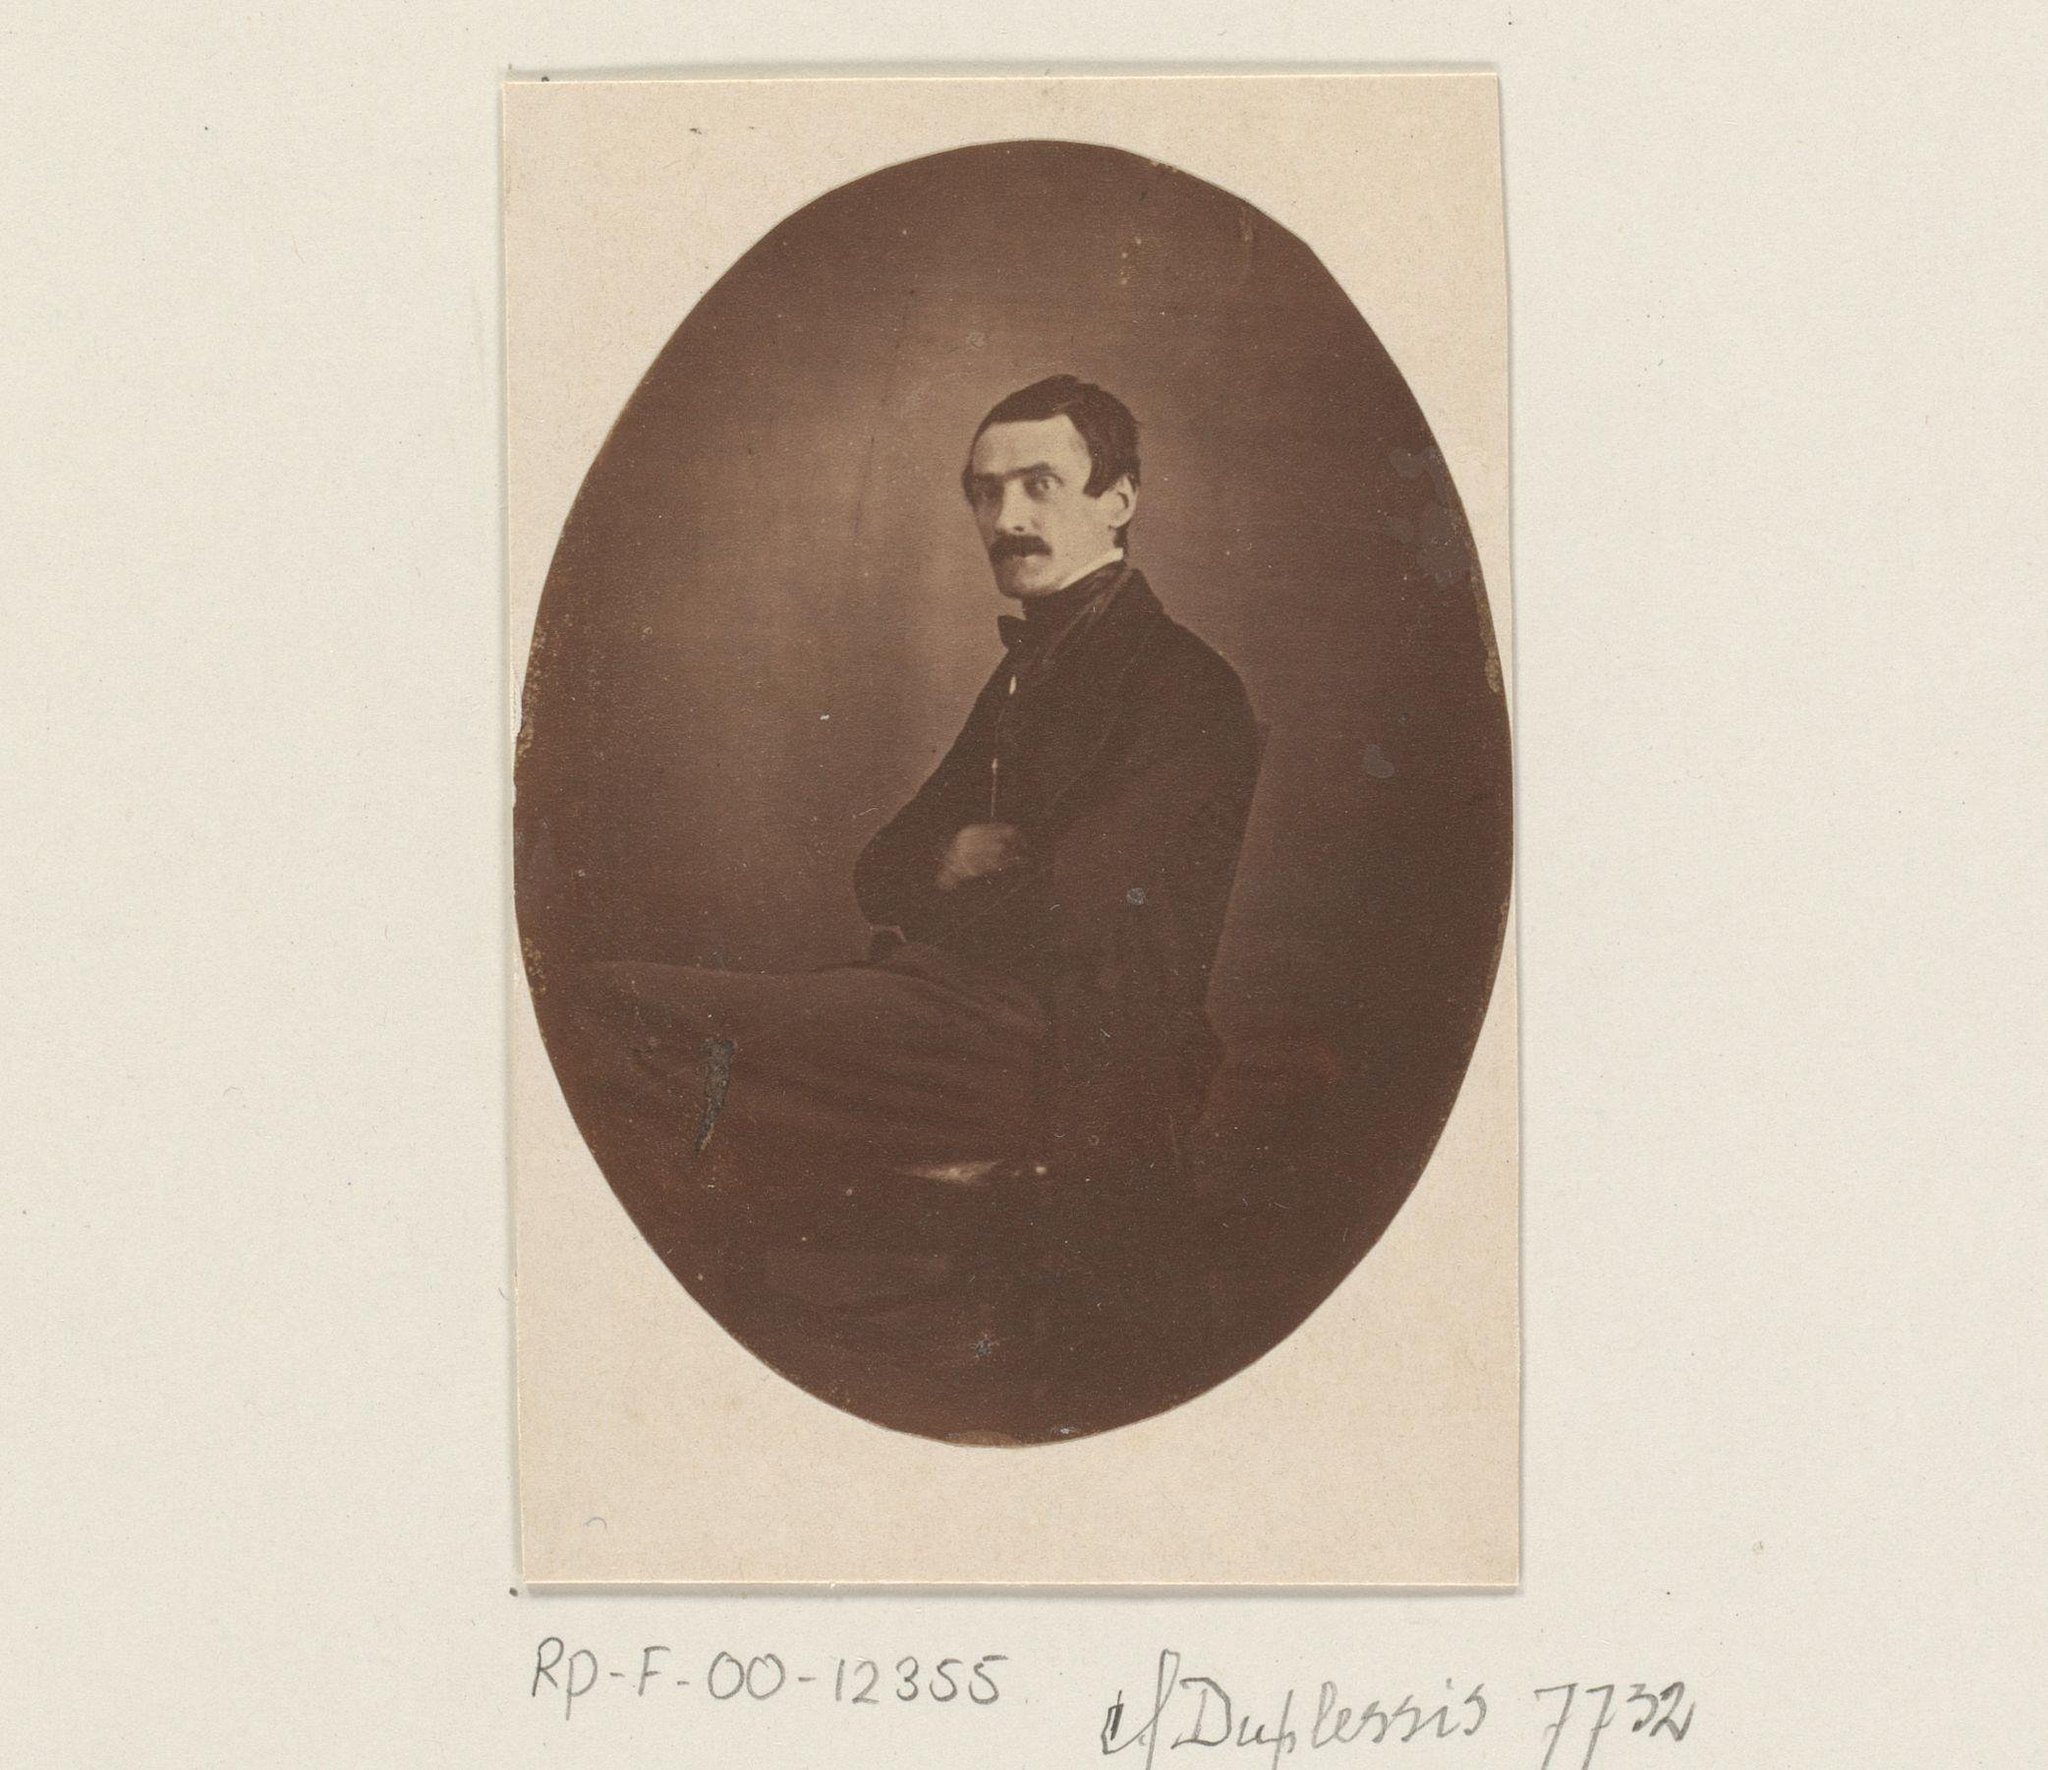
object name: photograph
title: Portret van Alexandre Calame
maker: Anonymous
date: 1851-1900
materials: cardboard, paper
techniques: albumen print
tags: painter, print maker, draughtsman, alexandre calame, portrait, self-portrait of artist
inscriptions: inscription: ‘A. Calame’